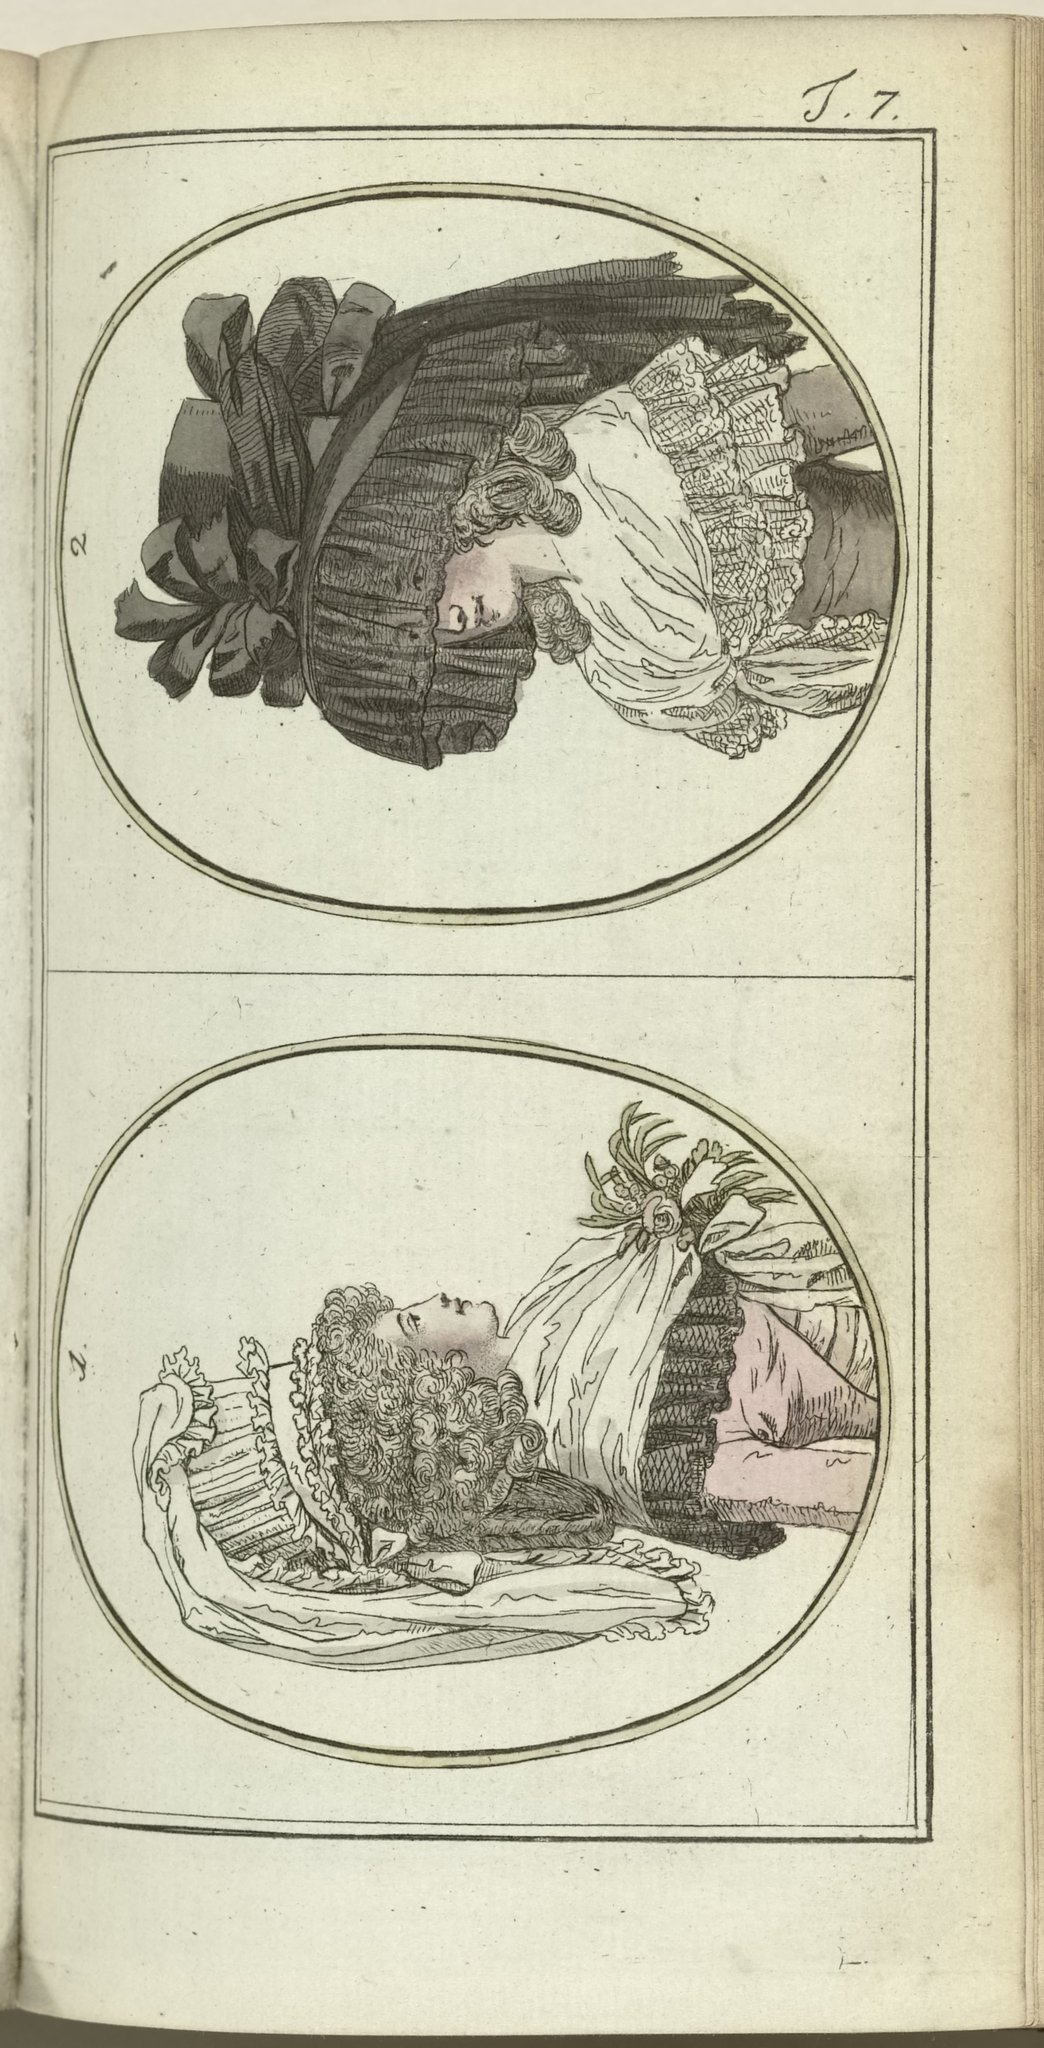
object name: magazine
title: Journal des Luxus und der Moden 1790, Band V, T.7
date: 1790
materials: paper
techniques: etching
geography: weimar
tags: fashion plates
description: Prent uit het modetijdschrift Journal des Luxus und der Moden, uitgegeven door Friedrich Justin Bertuch en Georg Melchior Kraus, Weimar, 1786-1826.